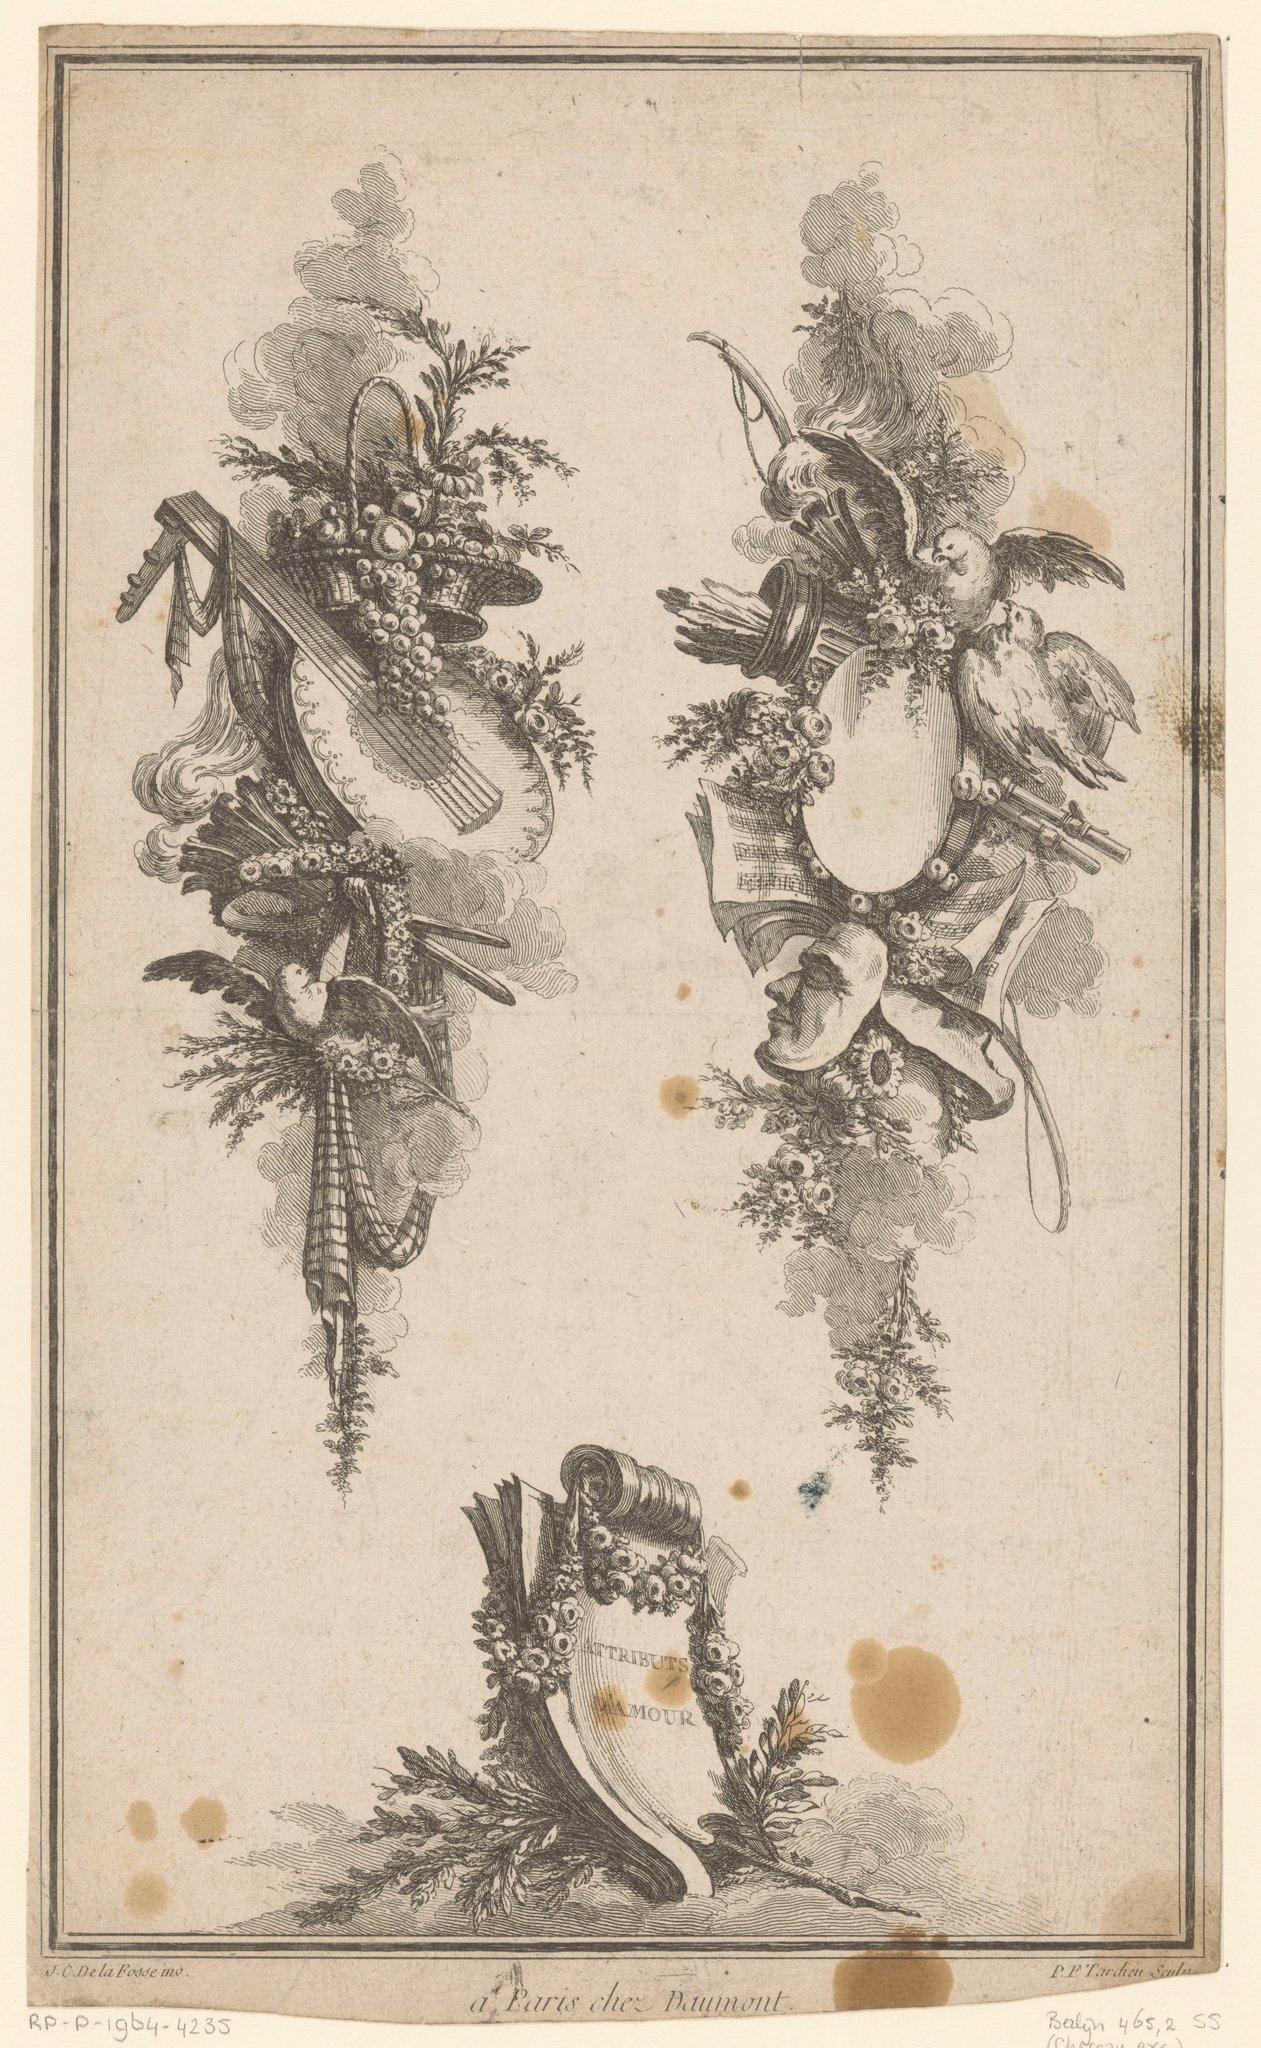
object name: print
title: Trofeeën met luit en tamboerijn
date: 1771-1775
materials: paper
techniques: engraving, etching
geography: paris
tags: trophy, i.e.: decorative arrangement of symbolic or typical objects ~ ornament, love: 'frau minne' and other allegories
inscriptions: collector's mark: Lugt 2760, collector's mark: Lugt 2228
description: Links een trofee met een mand met fruit, een luit, fakkels, kransen en een duif. Rechts een trofee met een fakkel, duiven, een pijlenkoker, een tamboerijn, bladmuziek en maskers.